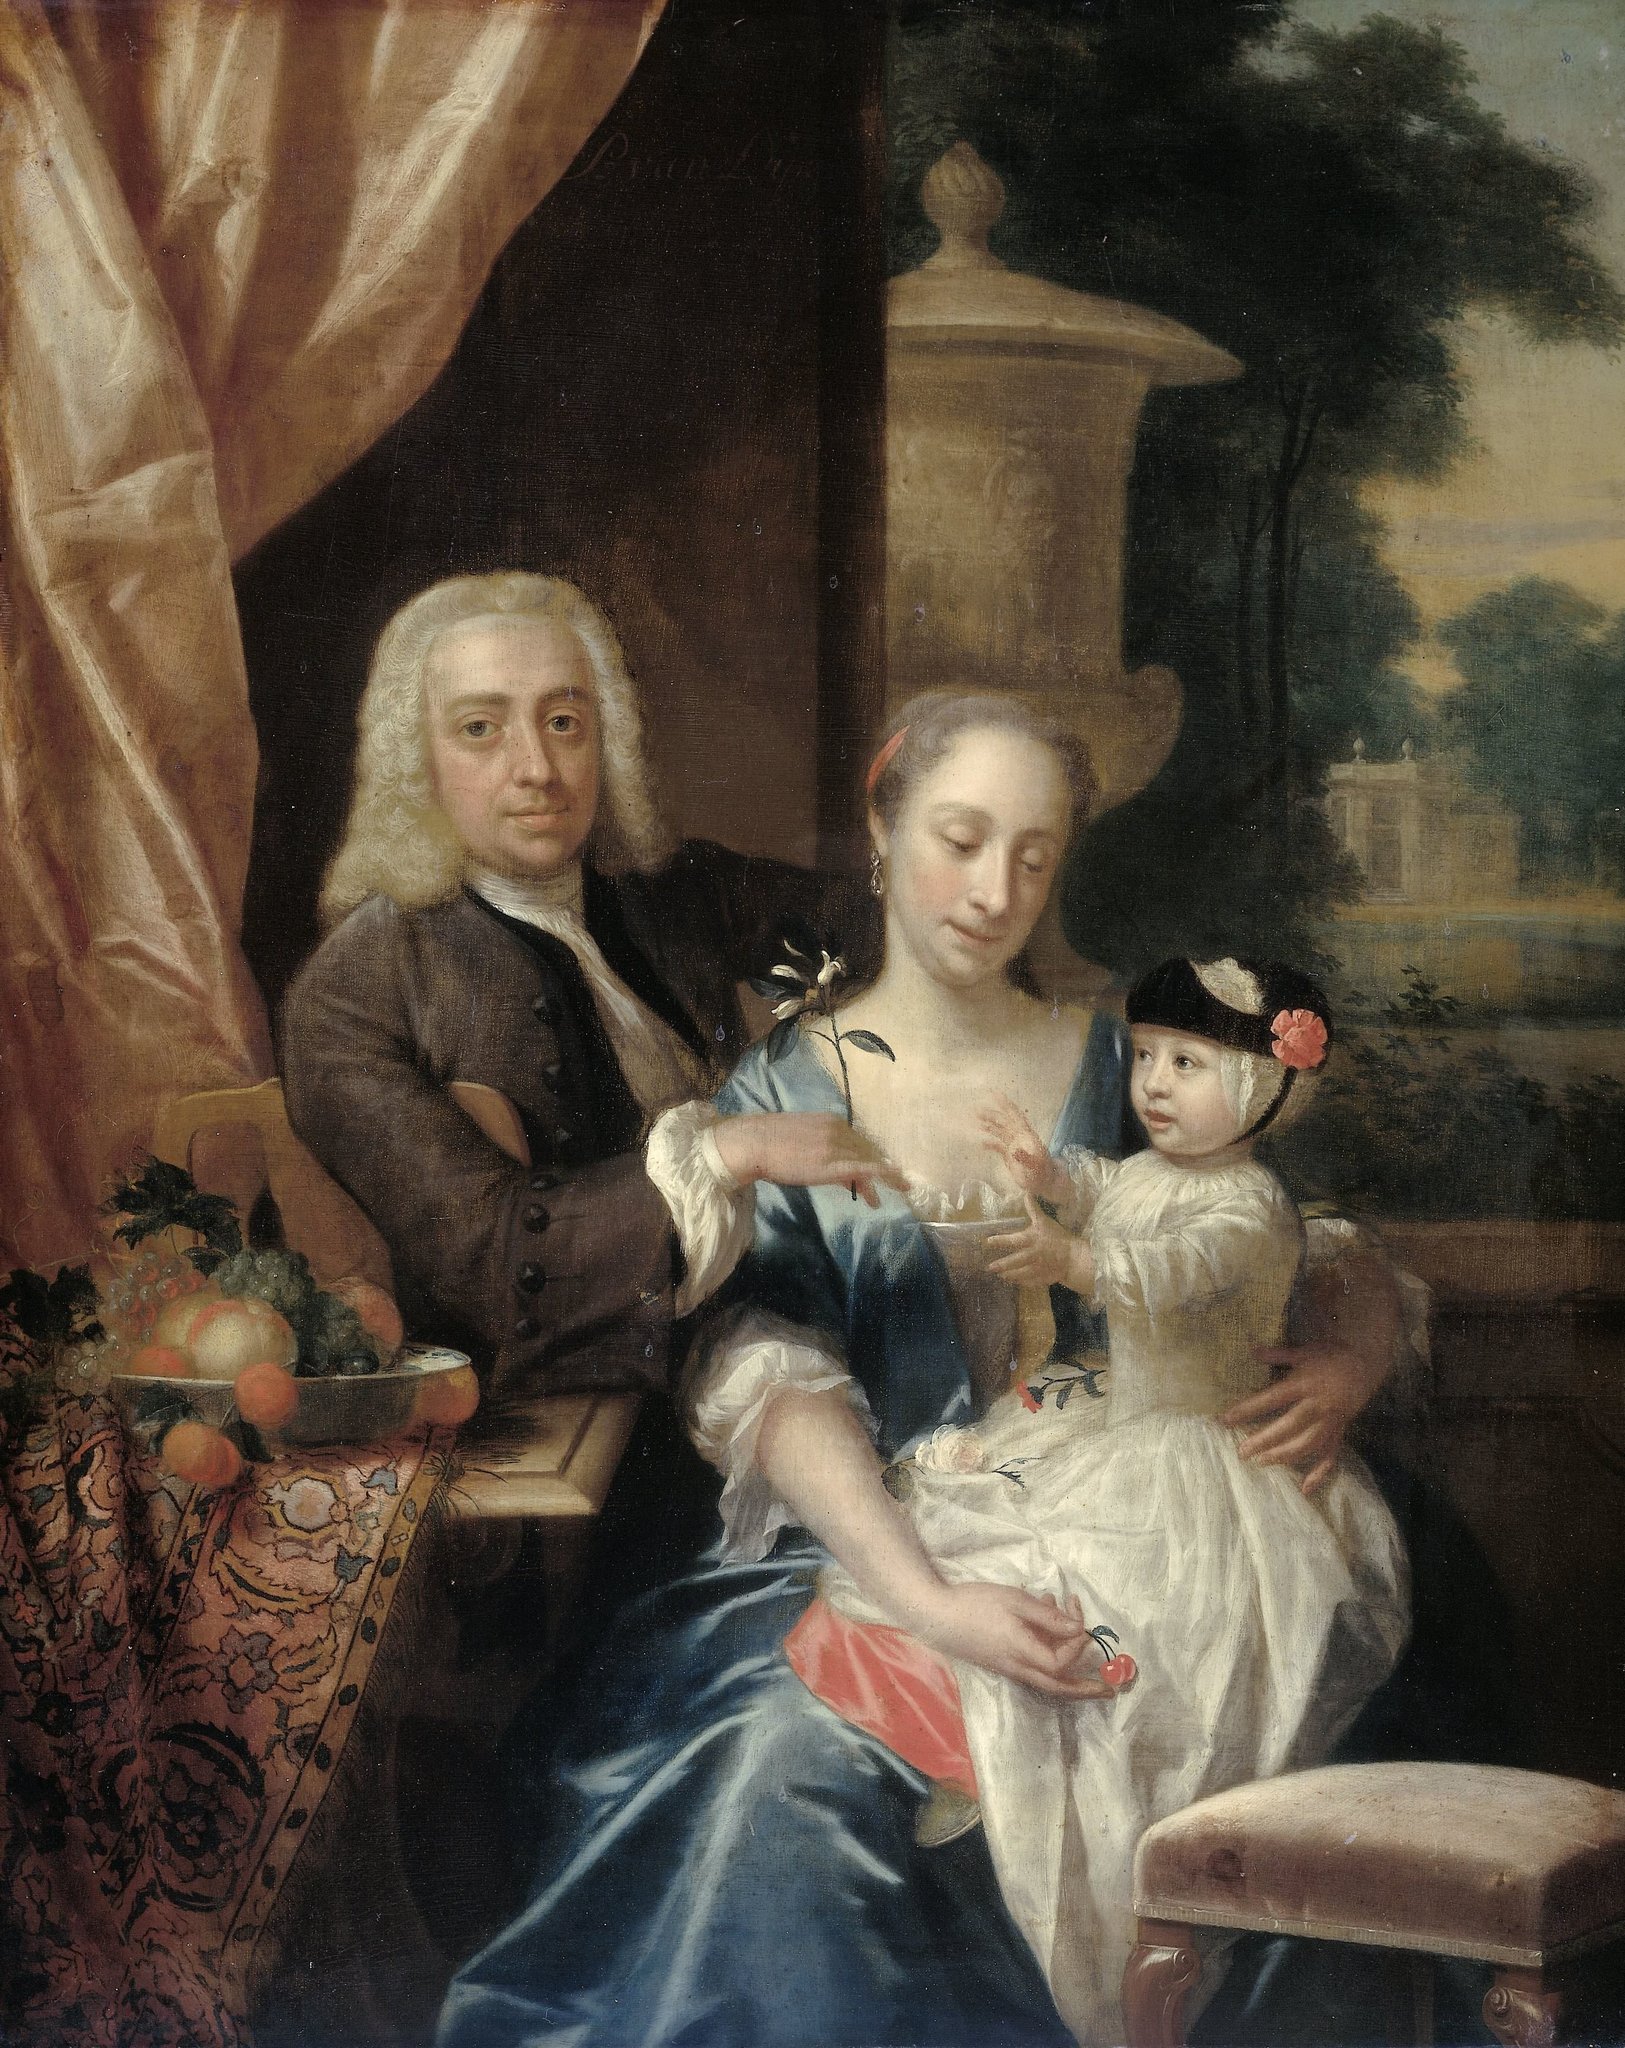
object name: painting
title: Isaac Parker, His Wife Justina Johanna Ramskrammer and Their Son Willem Alexander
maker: philip van dijk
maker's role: draughtsman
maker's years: 1683-1753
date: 1742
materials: oil, panel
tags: historical persons - bb - woman, family group, especially parents with their child(ren), historical persons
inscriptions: signature and date: ‘P. van Dijk. 1742’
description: Isaac Parker and Justina Ramskrammer had previously had their portrait painted by Philip van Dijk. By the time Willem Alexander was born they had been married for sixteen years. That was probably the reason behind ordering this new, loving family portrait. The grapes and peaches on the table symbolize fertility, a long-held wish that eventually came true.